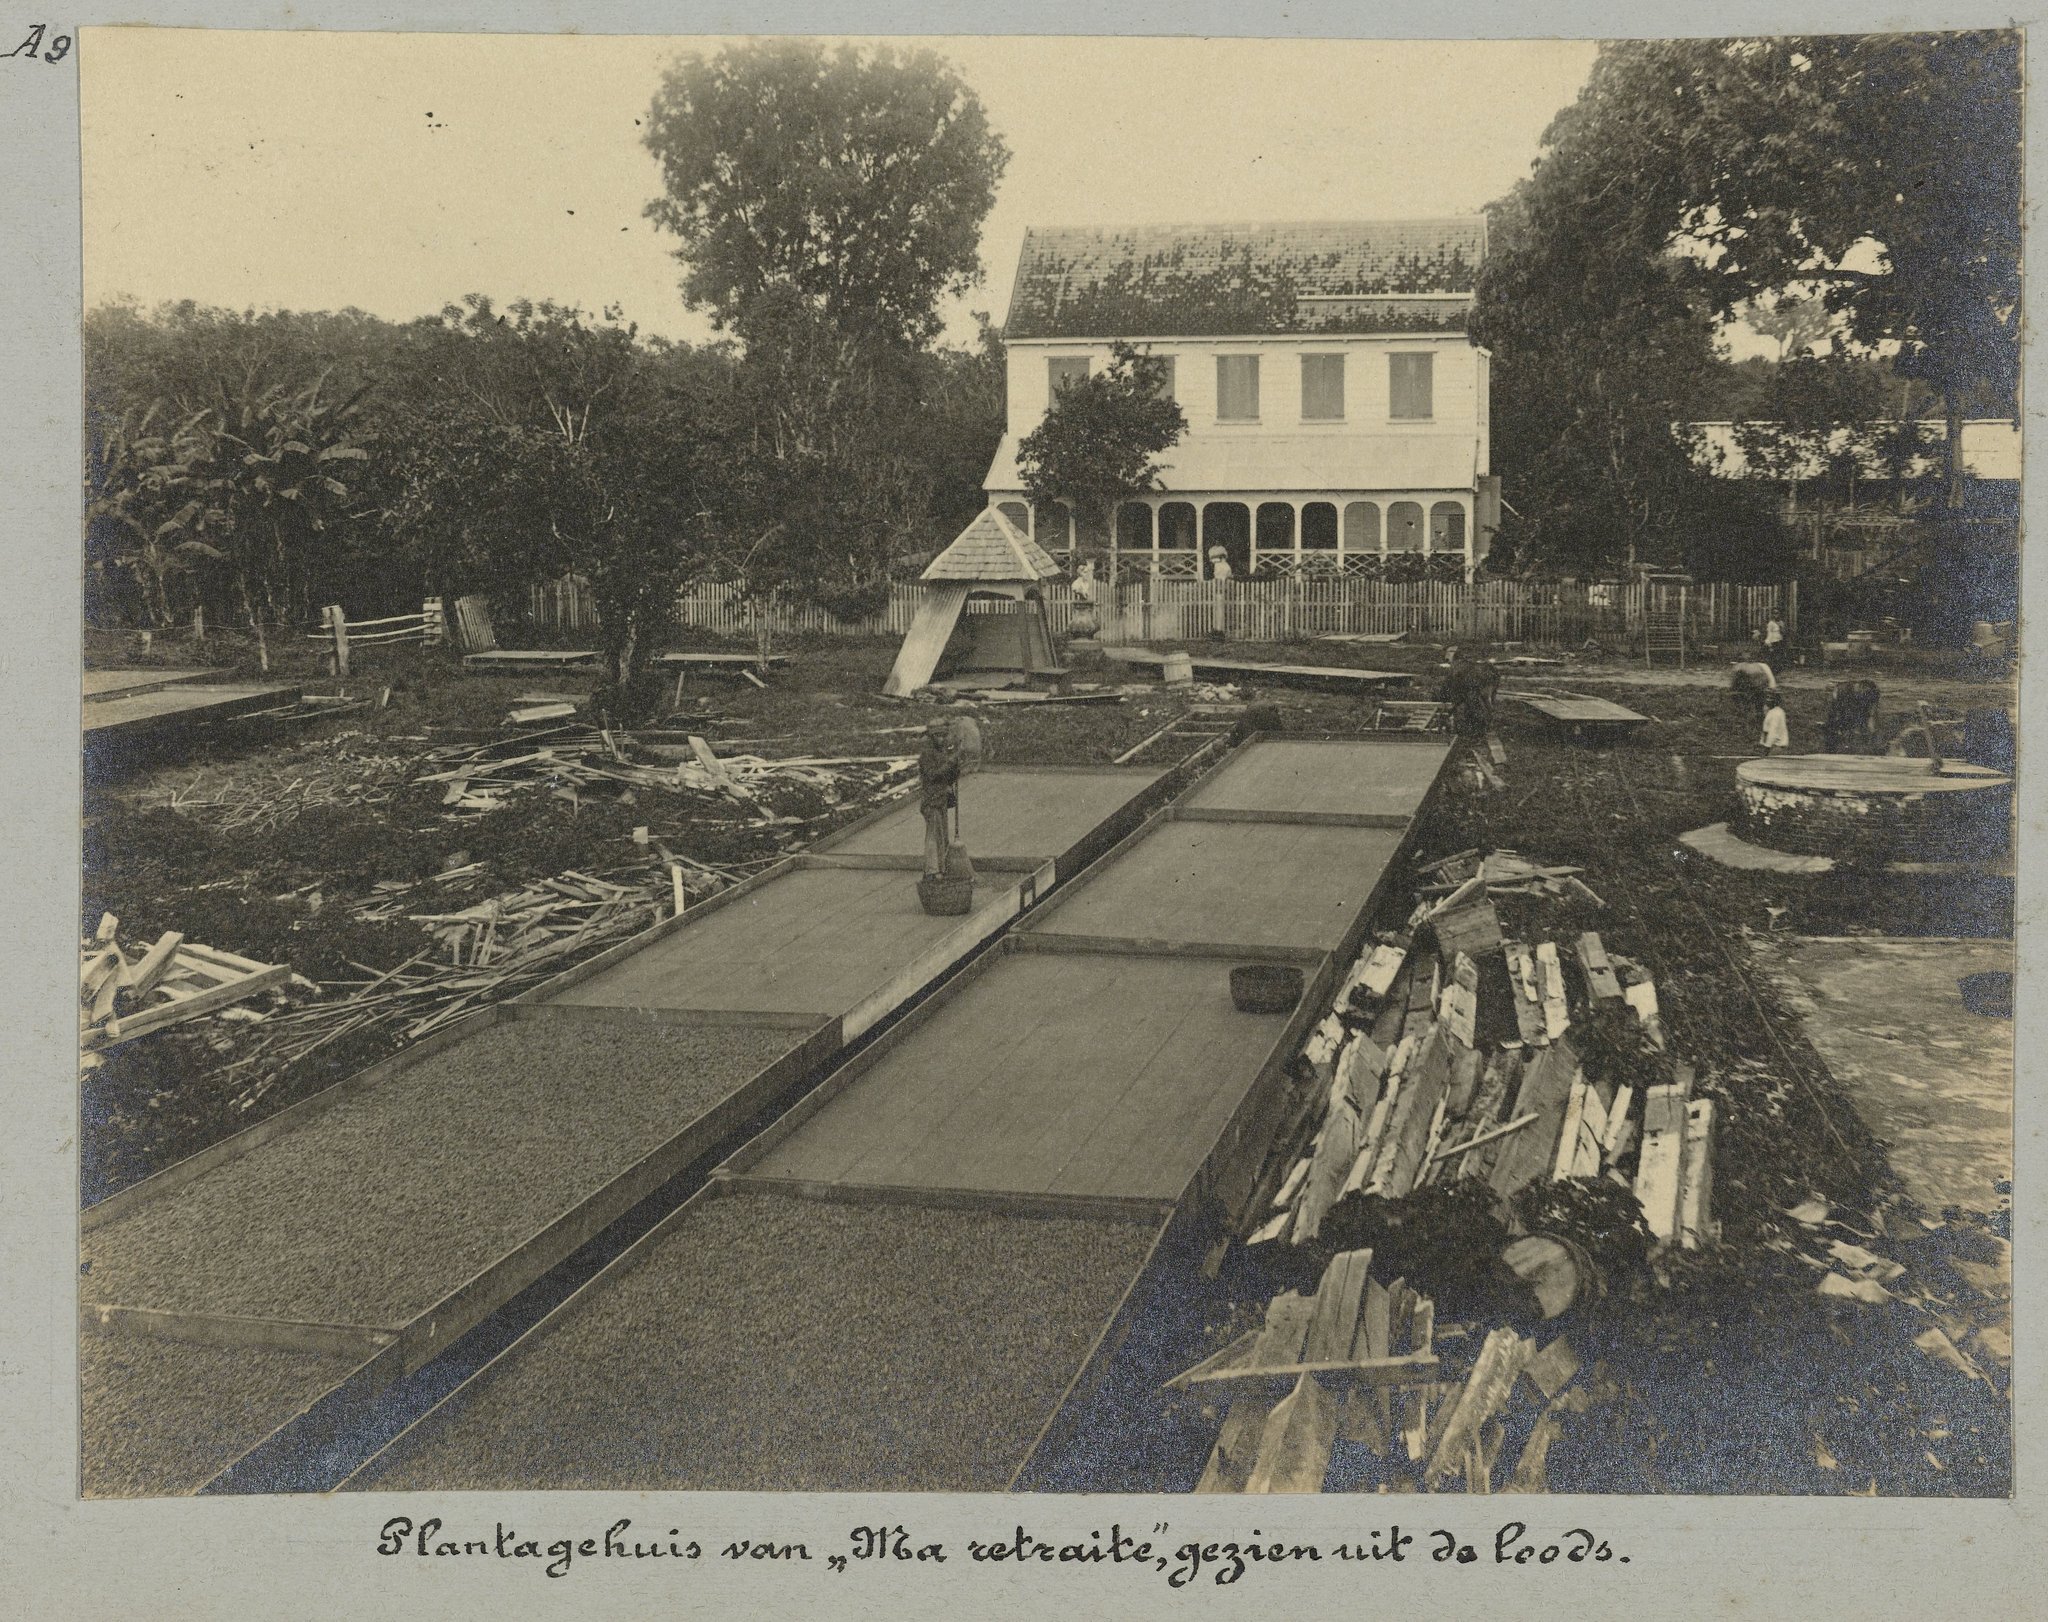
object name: photograph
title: Plantagehuis van "Ma retraite", gezien uit de loods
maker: hendrik doijer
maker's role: engineer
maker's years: 1863-1925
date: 1903-1910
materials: photographic support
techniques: gelatin silver print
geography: suriname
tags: suriname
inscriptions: inscription: ‘A9 / Plantagehuis van "Ma retraite", gezien uit de loods.’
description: Gezicht op het plantagehuis van de plantage Ma Retraite gezien vanuit de loods, op de voorgrond verschillende langwerpige bakken, waarschijnlijk gevuld met cacaobonen. Onderdeel van het fotoalbum Souvenir de Voyage (deel 1), over het leven van de familie Doijer in en rond de plantage Ma Retraite in Suriname in de jaren 1903-1910.